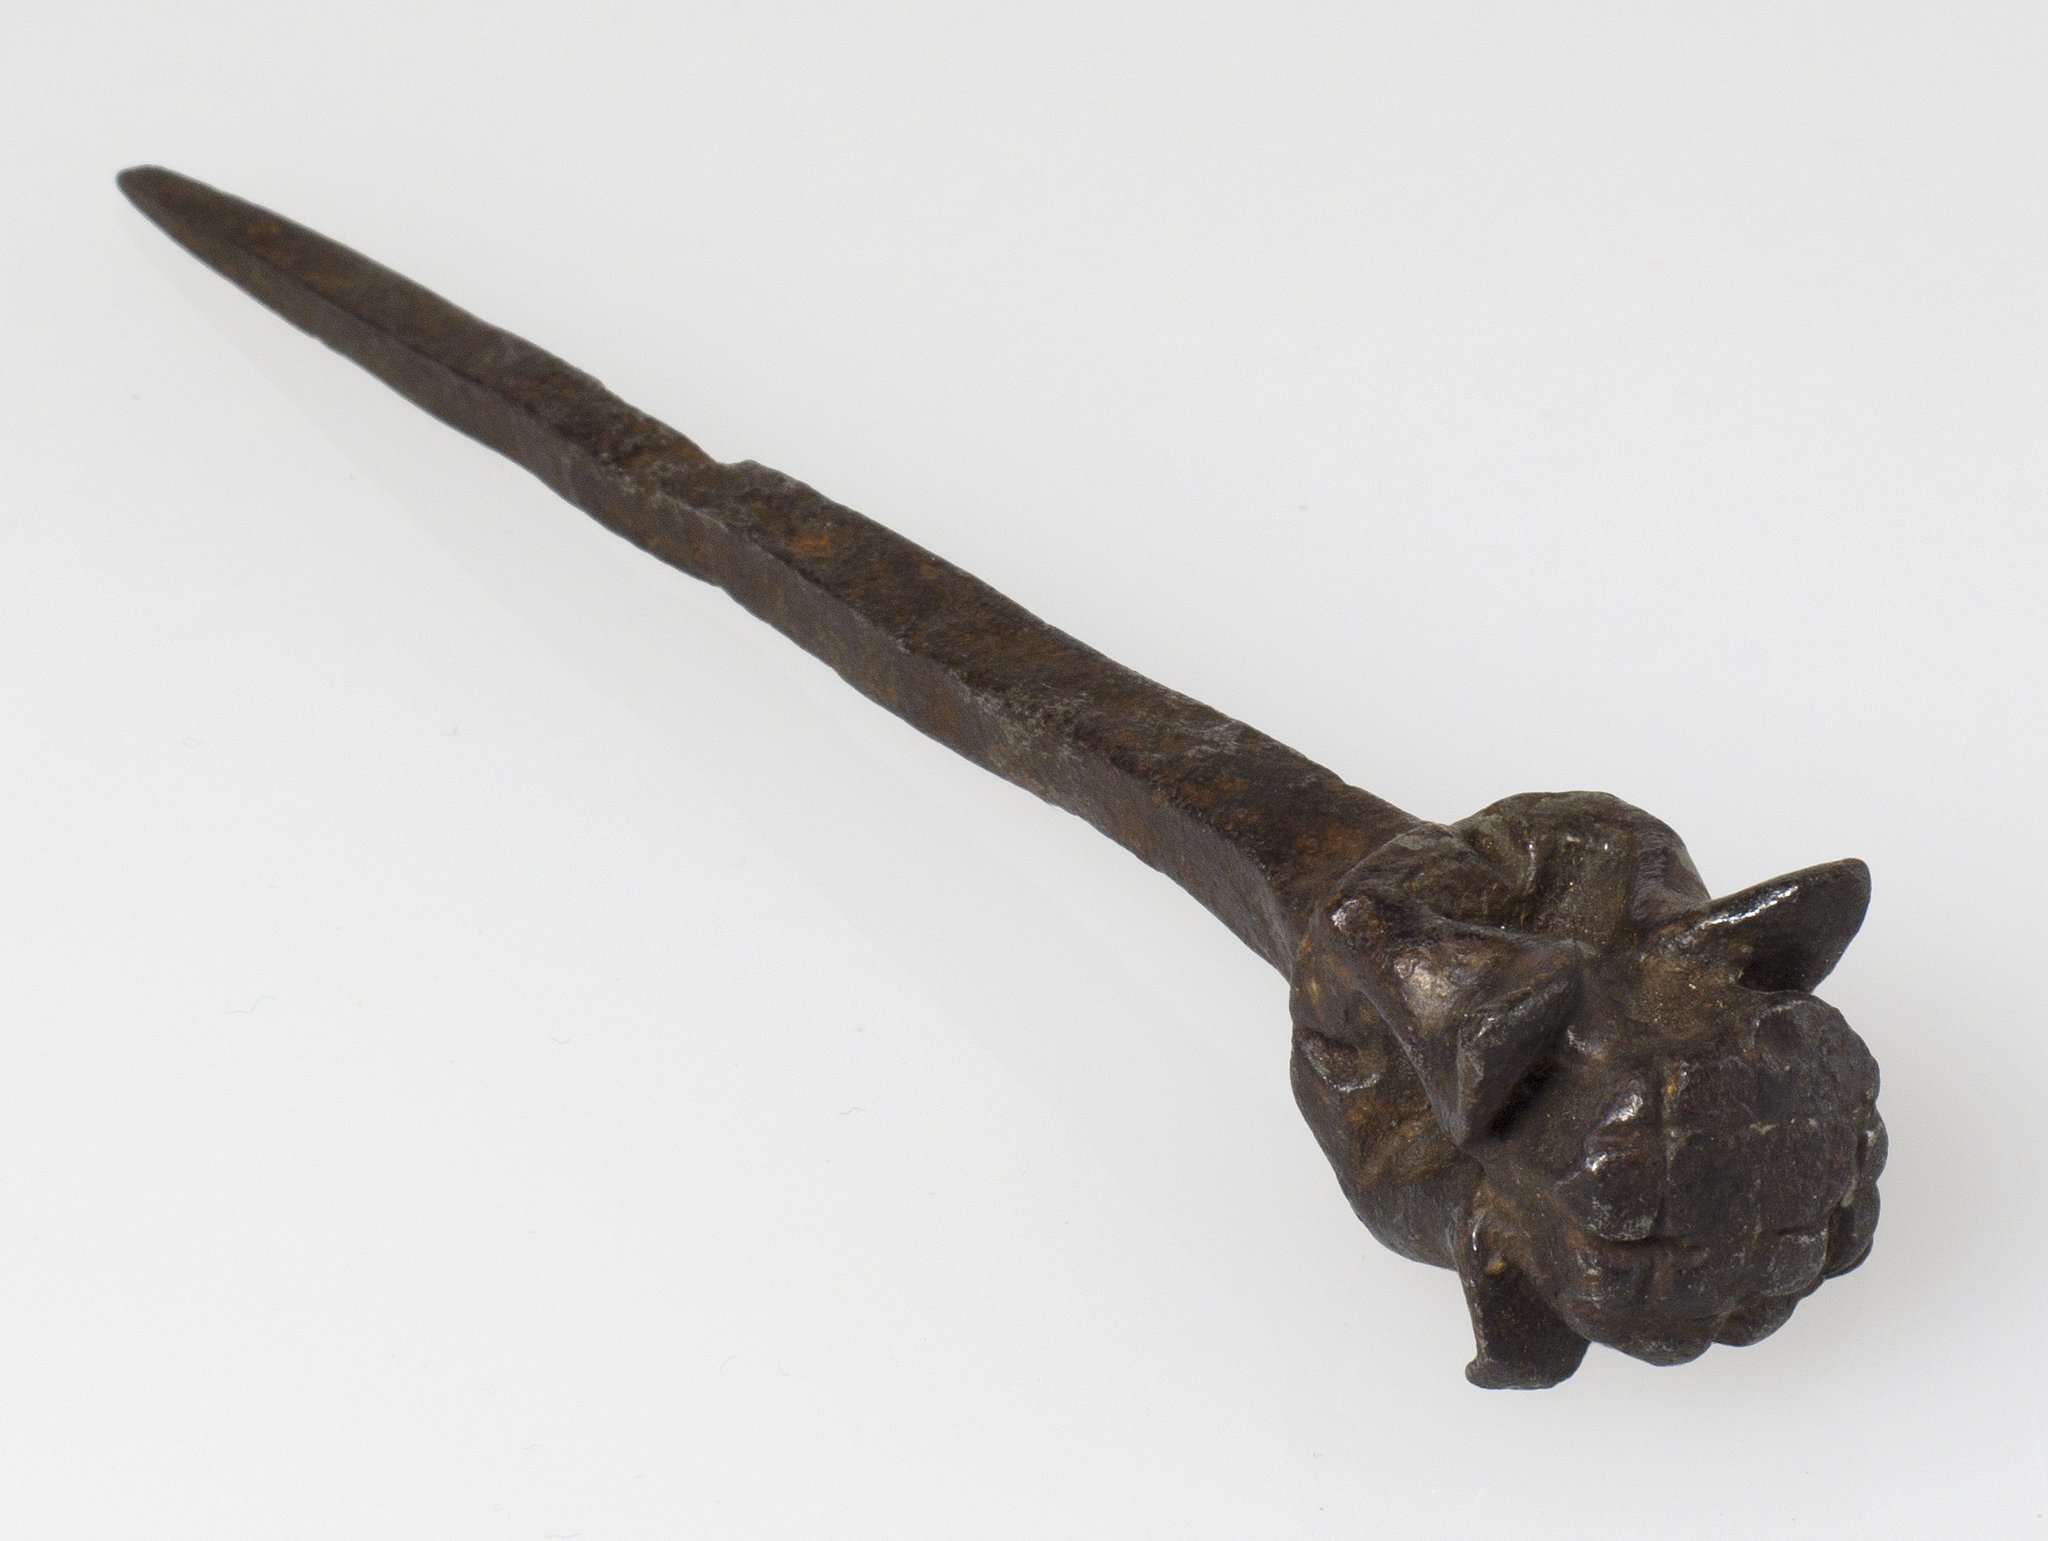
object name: nail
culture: european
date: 1401-1600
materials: iron